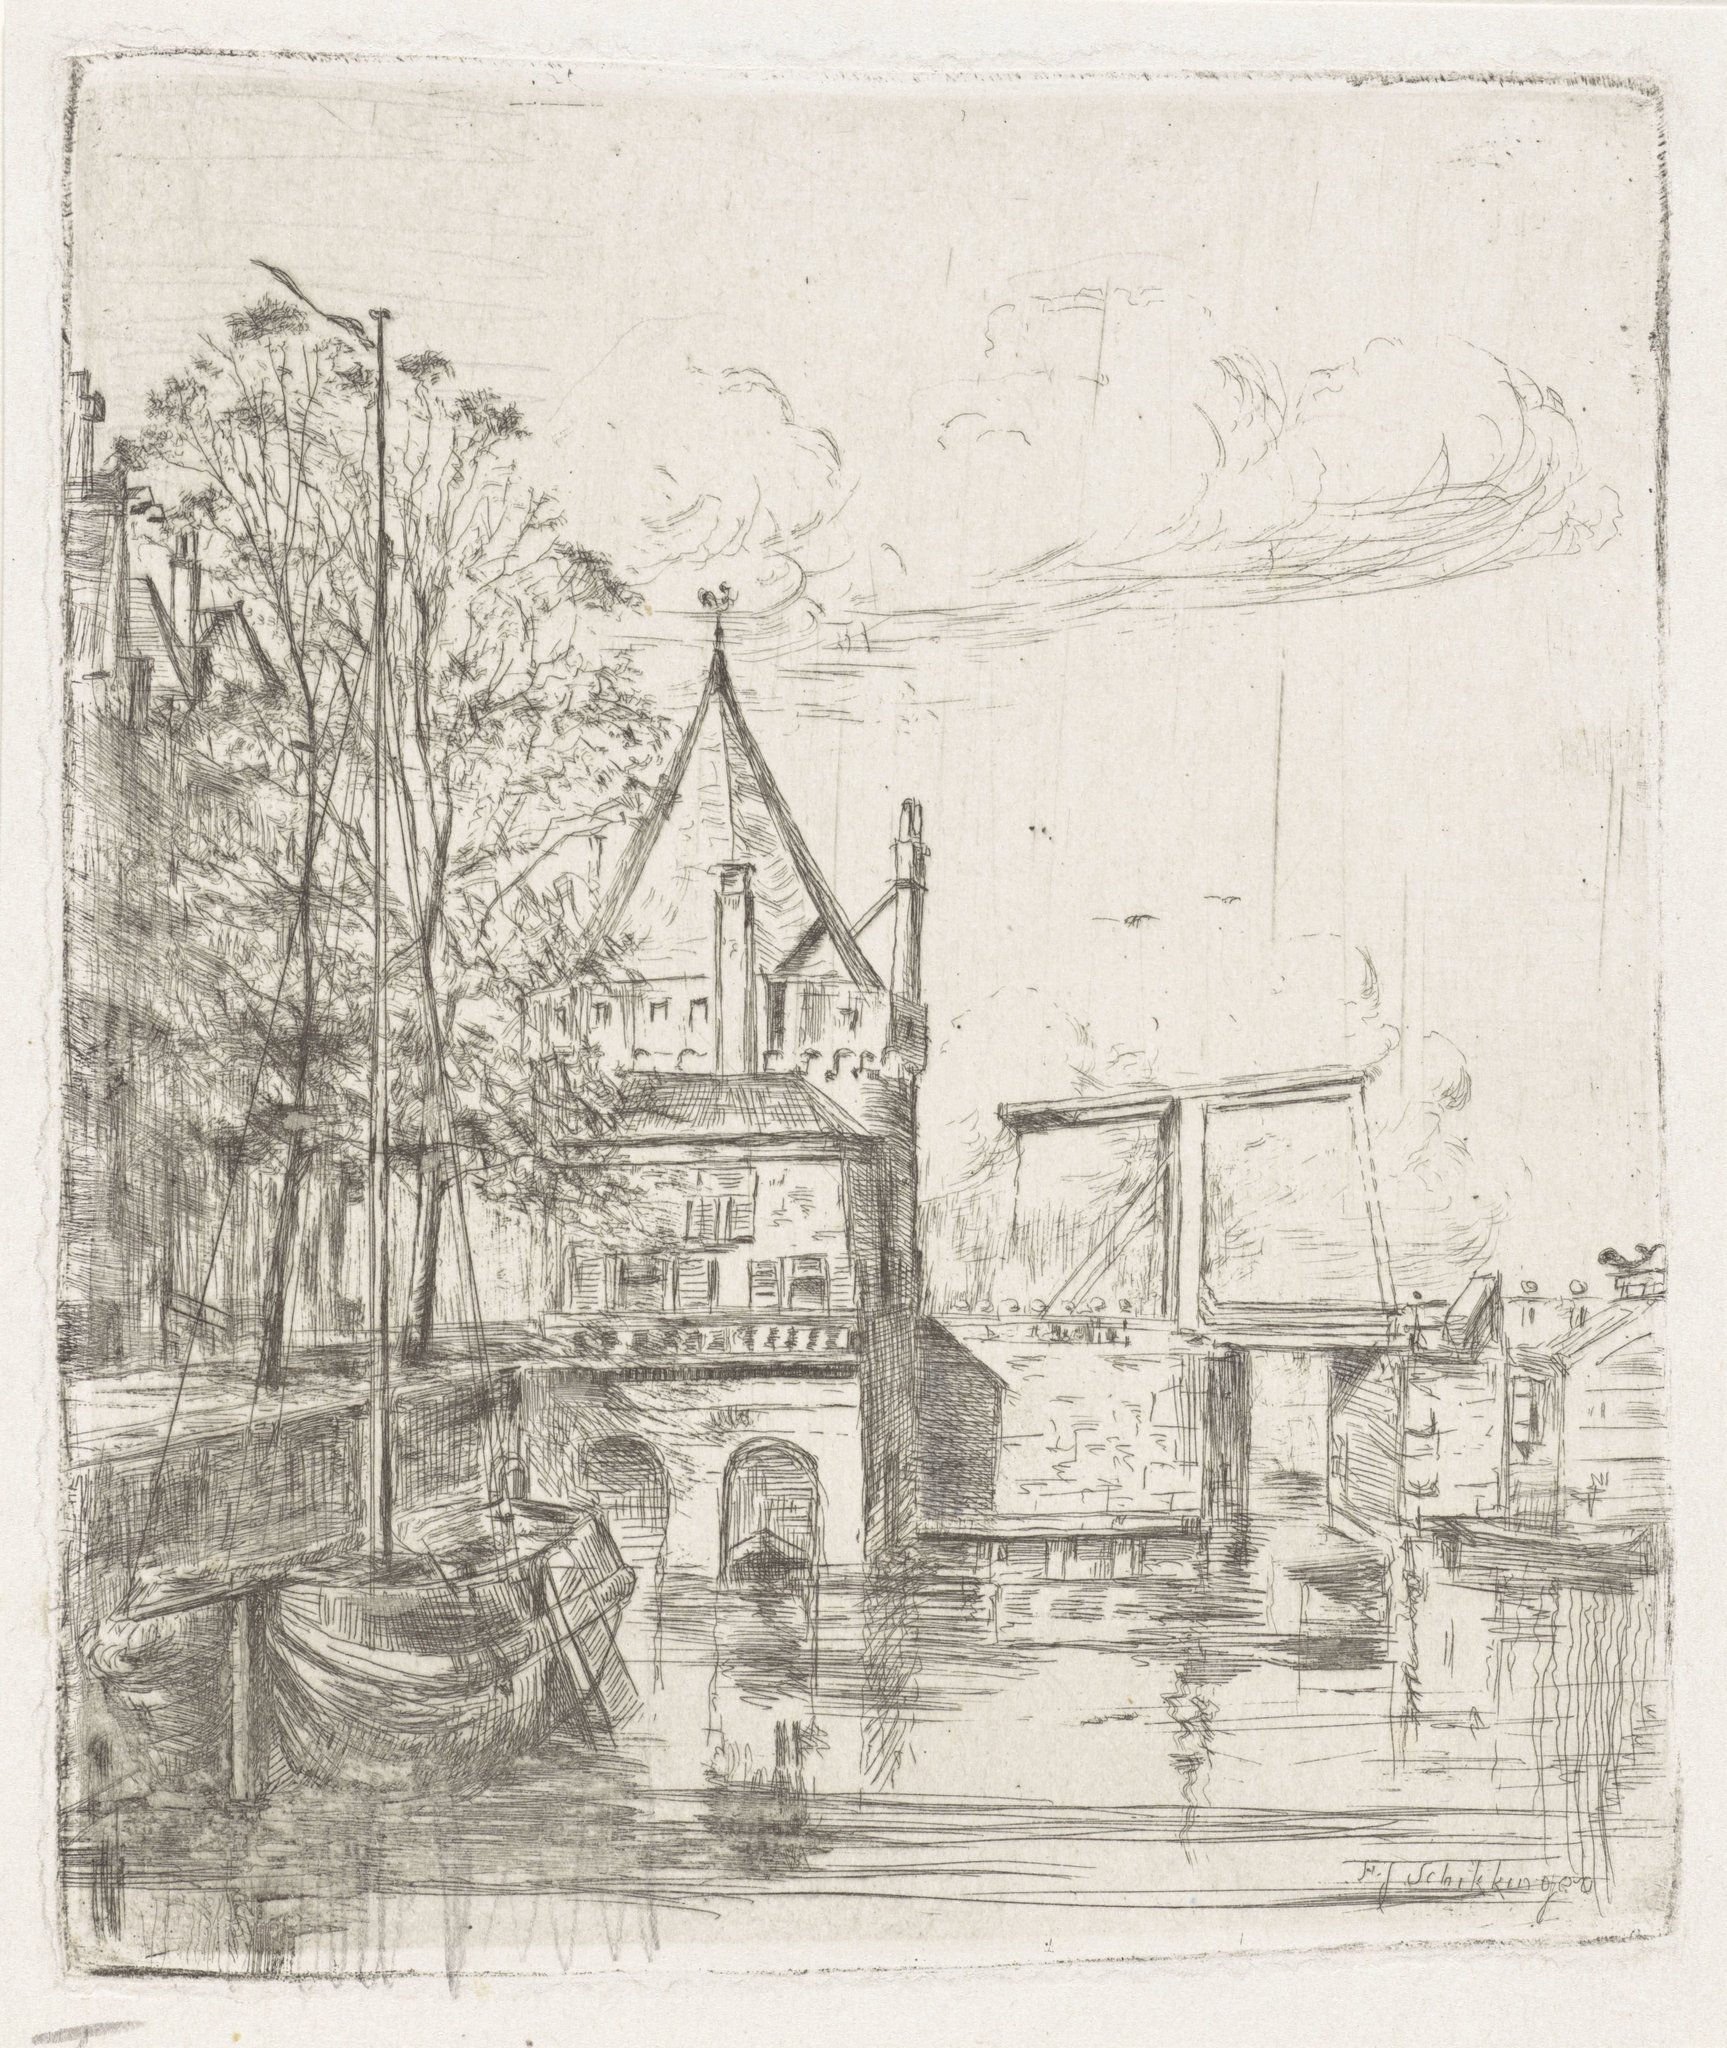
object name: print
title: Gezicht op de Schreierstoren te Amsterdam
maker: frans schikkinger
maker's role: print maker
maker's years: 1838-1902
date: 1848-1902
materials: paper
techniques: drypoint, etching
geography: amsterdam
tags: tower, clock tower ~ monumental adornment, canals, waters (in city)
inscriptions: collector's mark: Lugt 2228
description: Gezicht op de Schreierstoren vanaf het water van de Geldersekade.